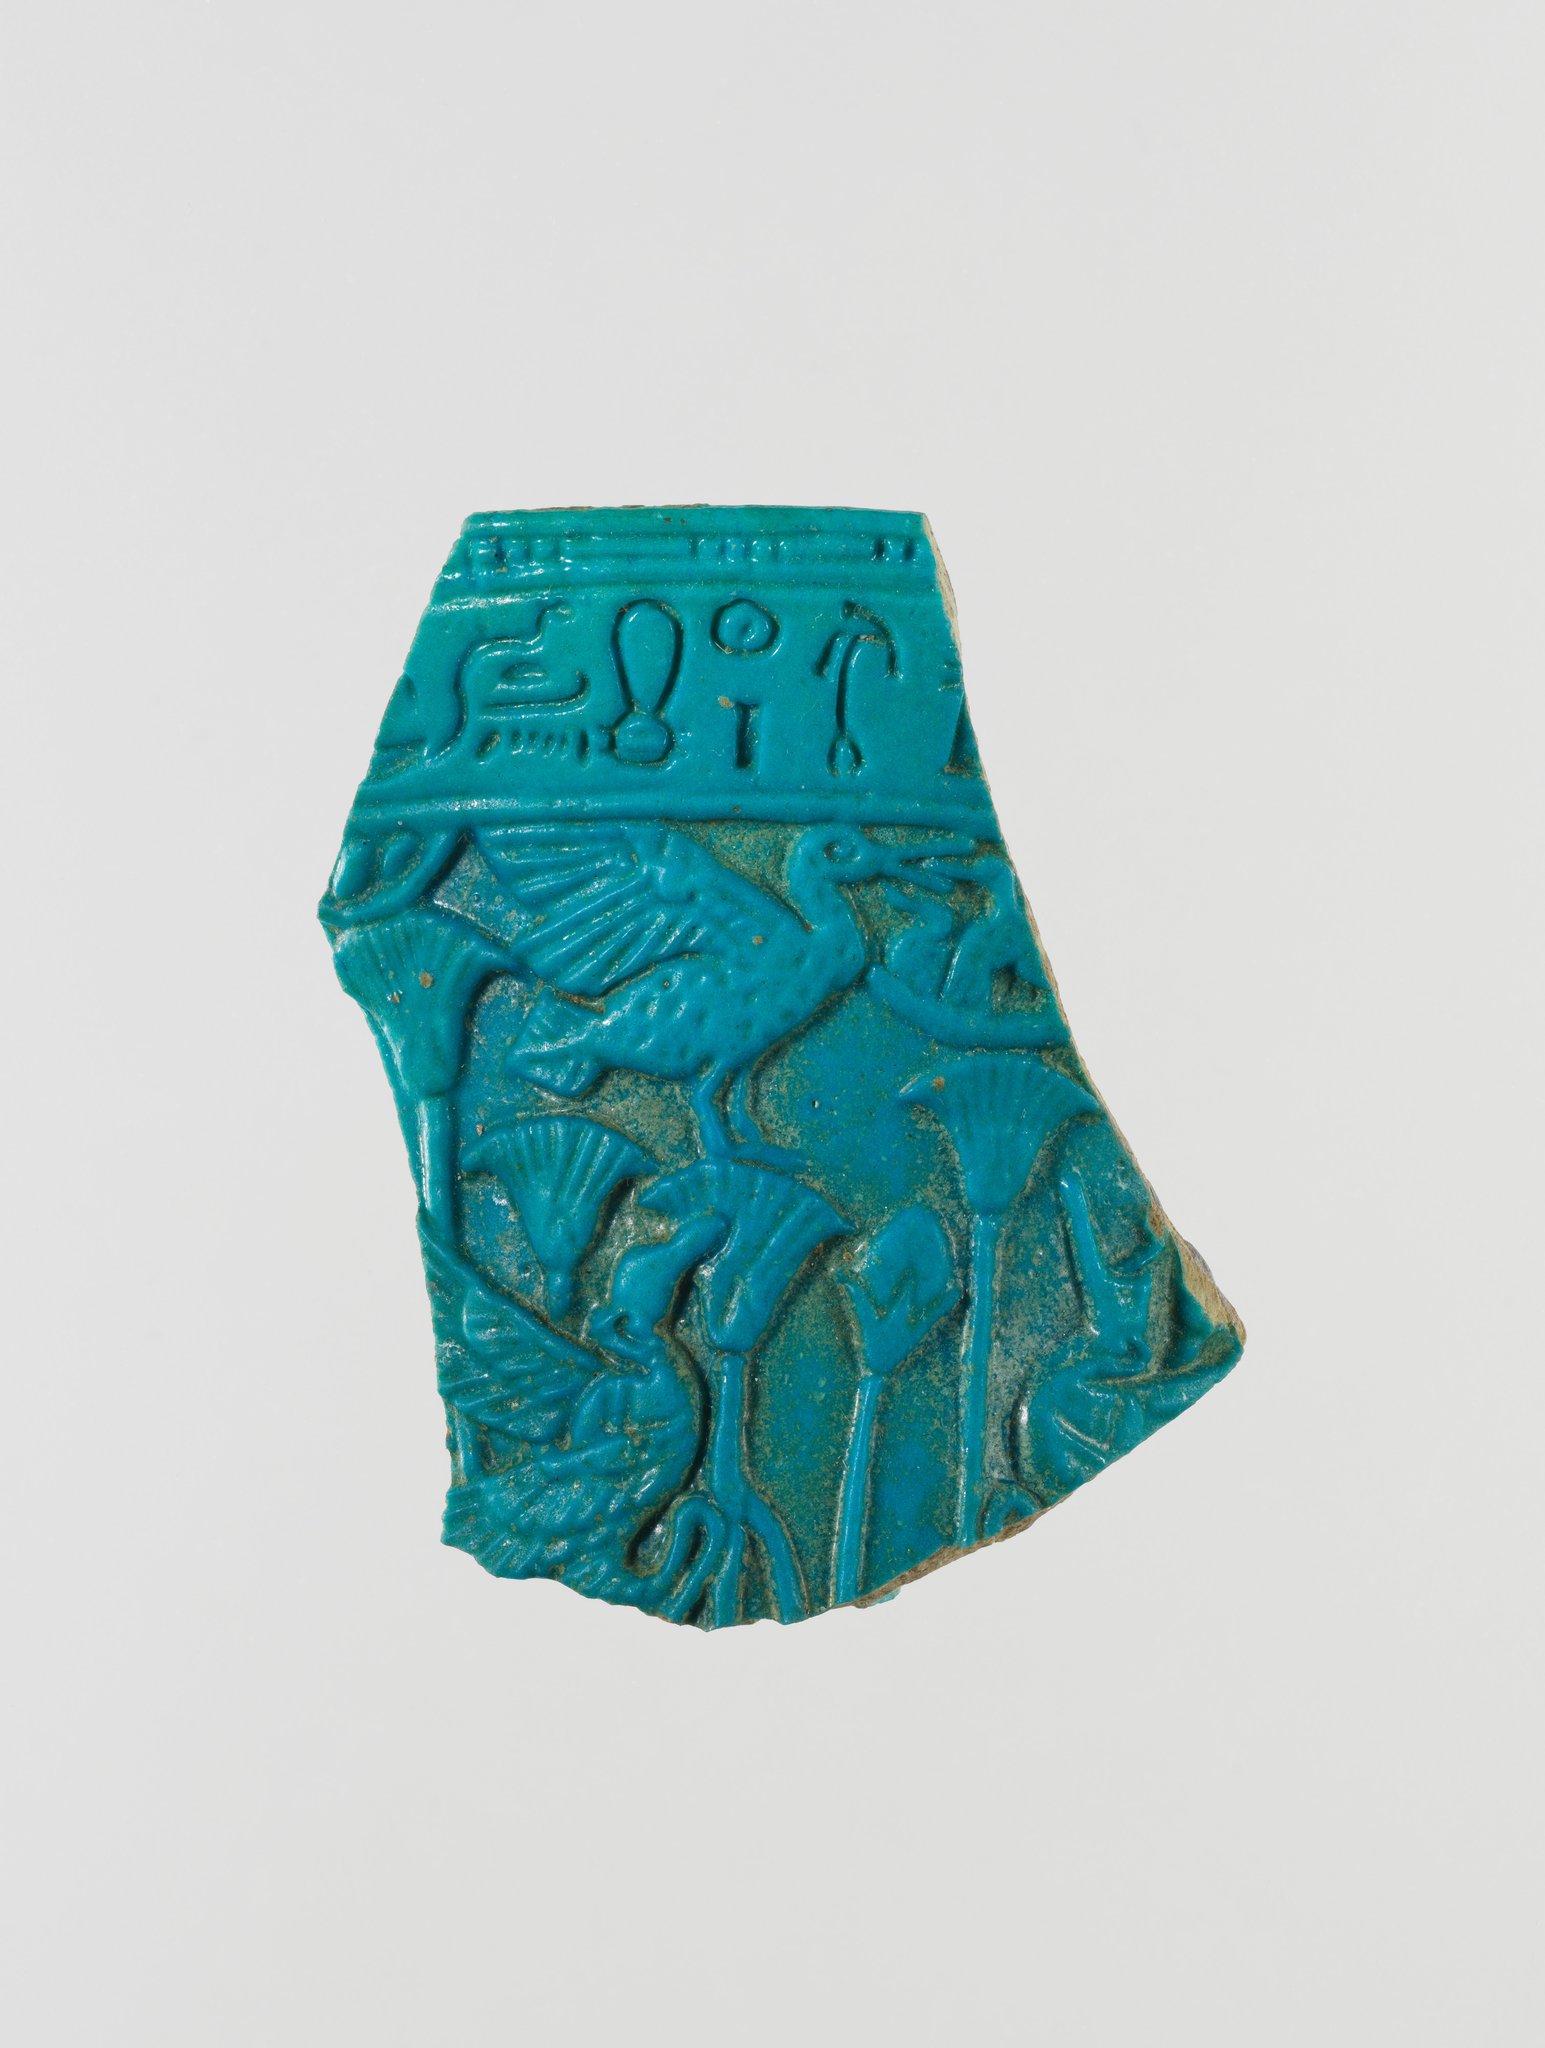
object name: chalice, cup, lotiform, relief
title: Fragmentary Lotiform Chalice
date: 1070-925 BCE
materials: faience